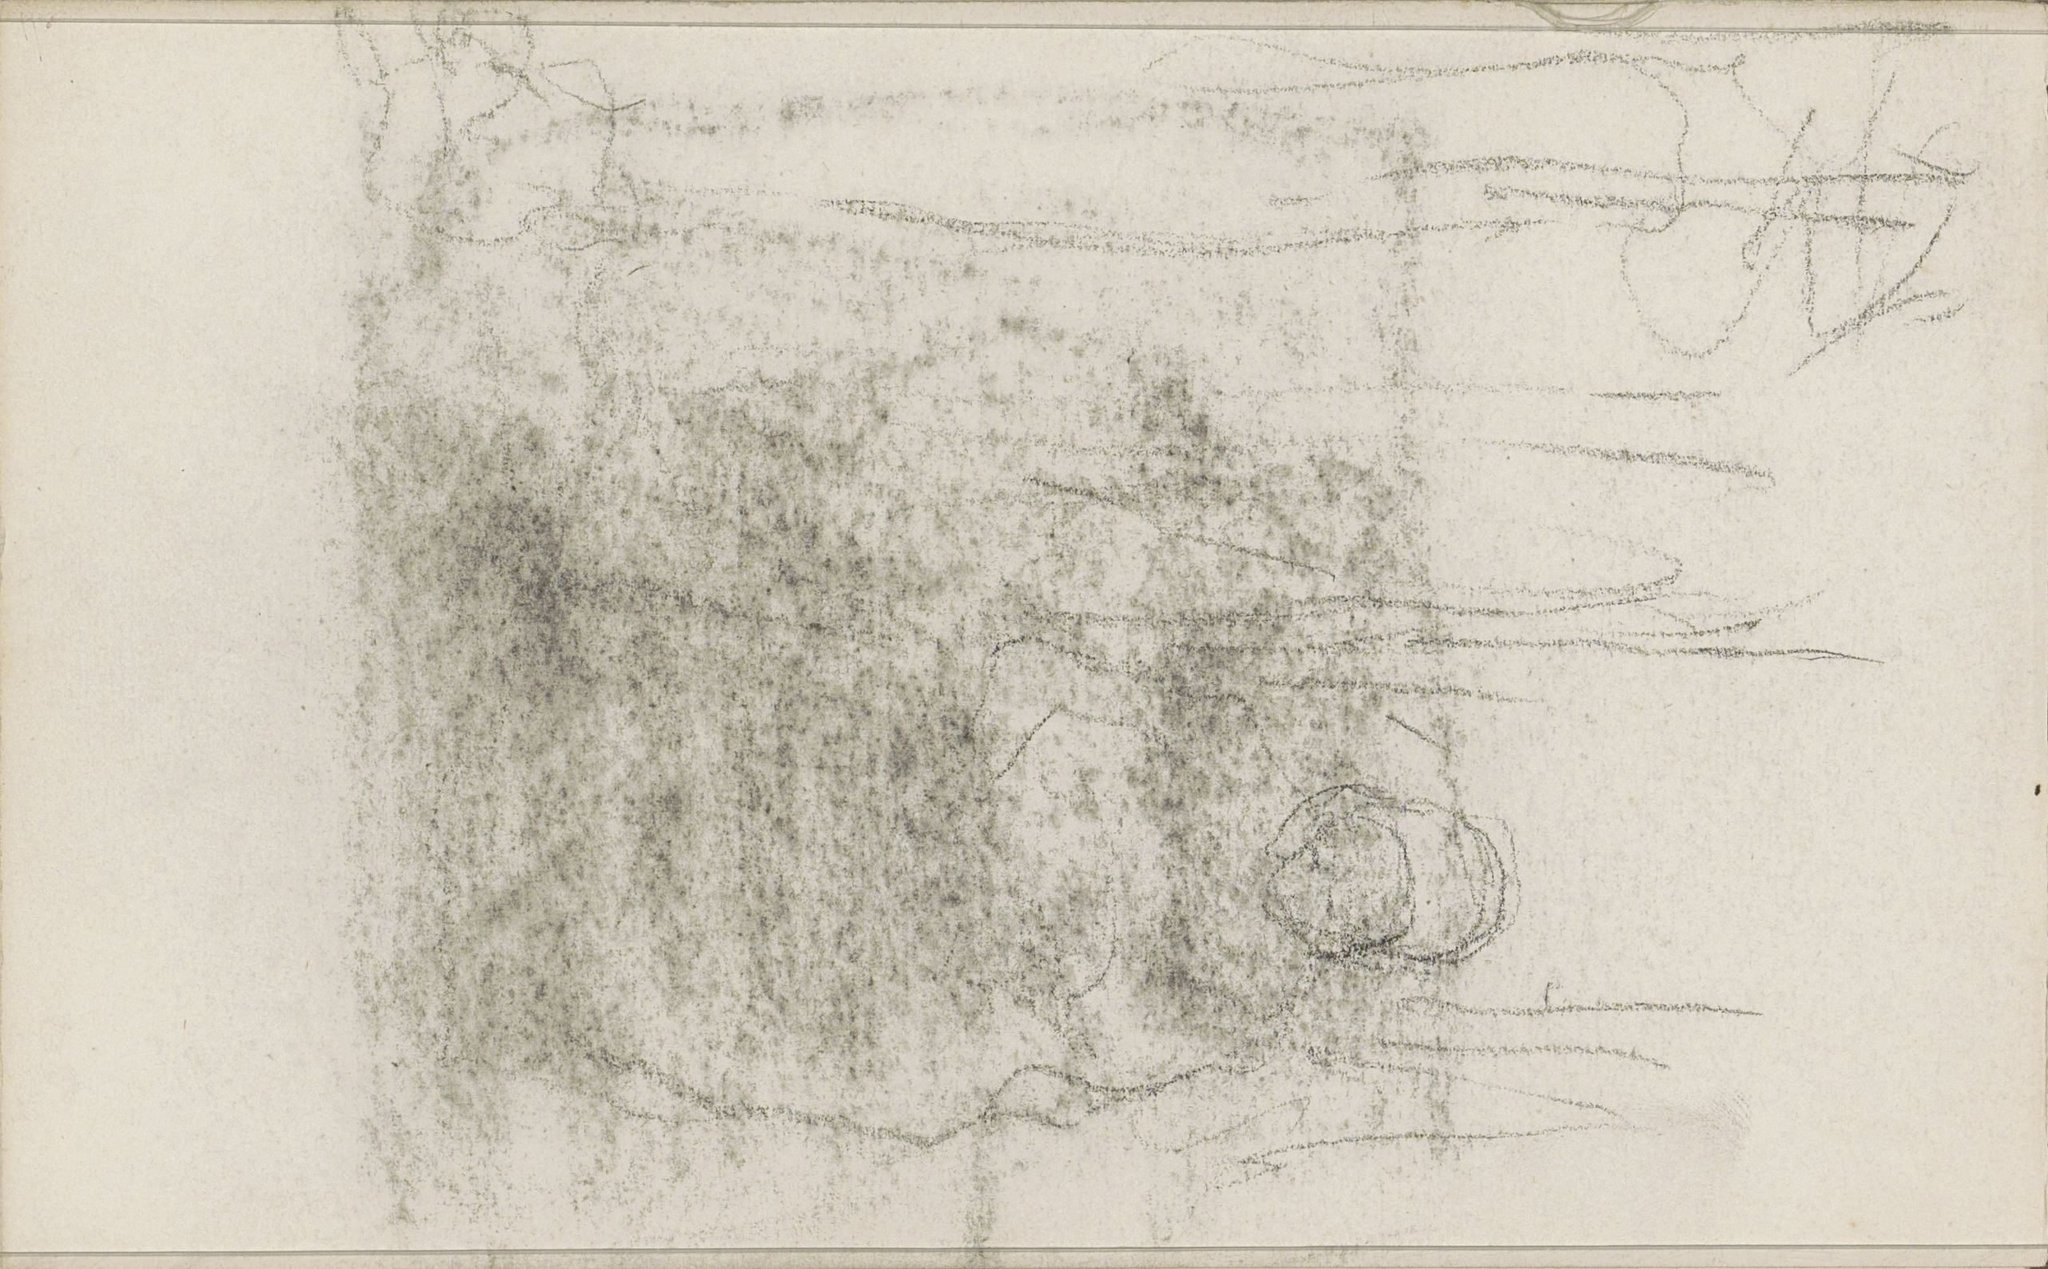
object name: sketchbook leaf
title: Zittende vrouw met een muts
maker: anton mauve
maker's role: draughtsman, painter, print maker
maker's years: 1838-1888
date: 1848-1888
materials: chalk, paper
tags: sitting figure (+ female (human being) (not to be used where -aa- is prescribed))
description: Blad 35 verso uit een schetsboek met 41 bladen.